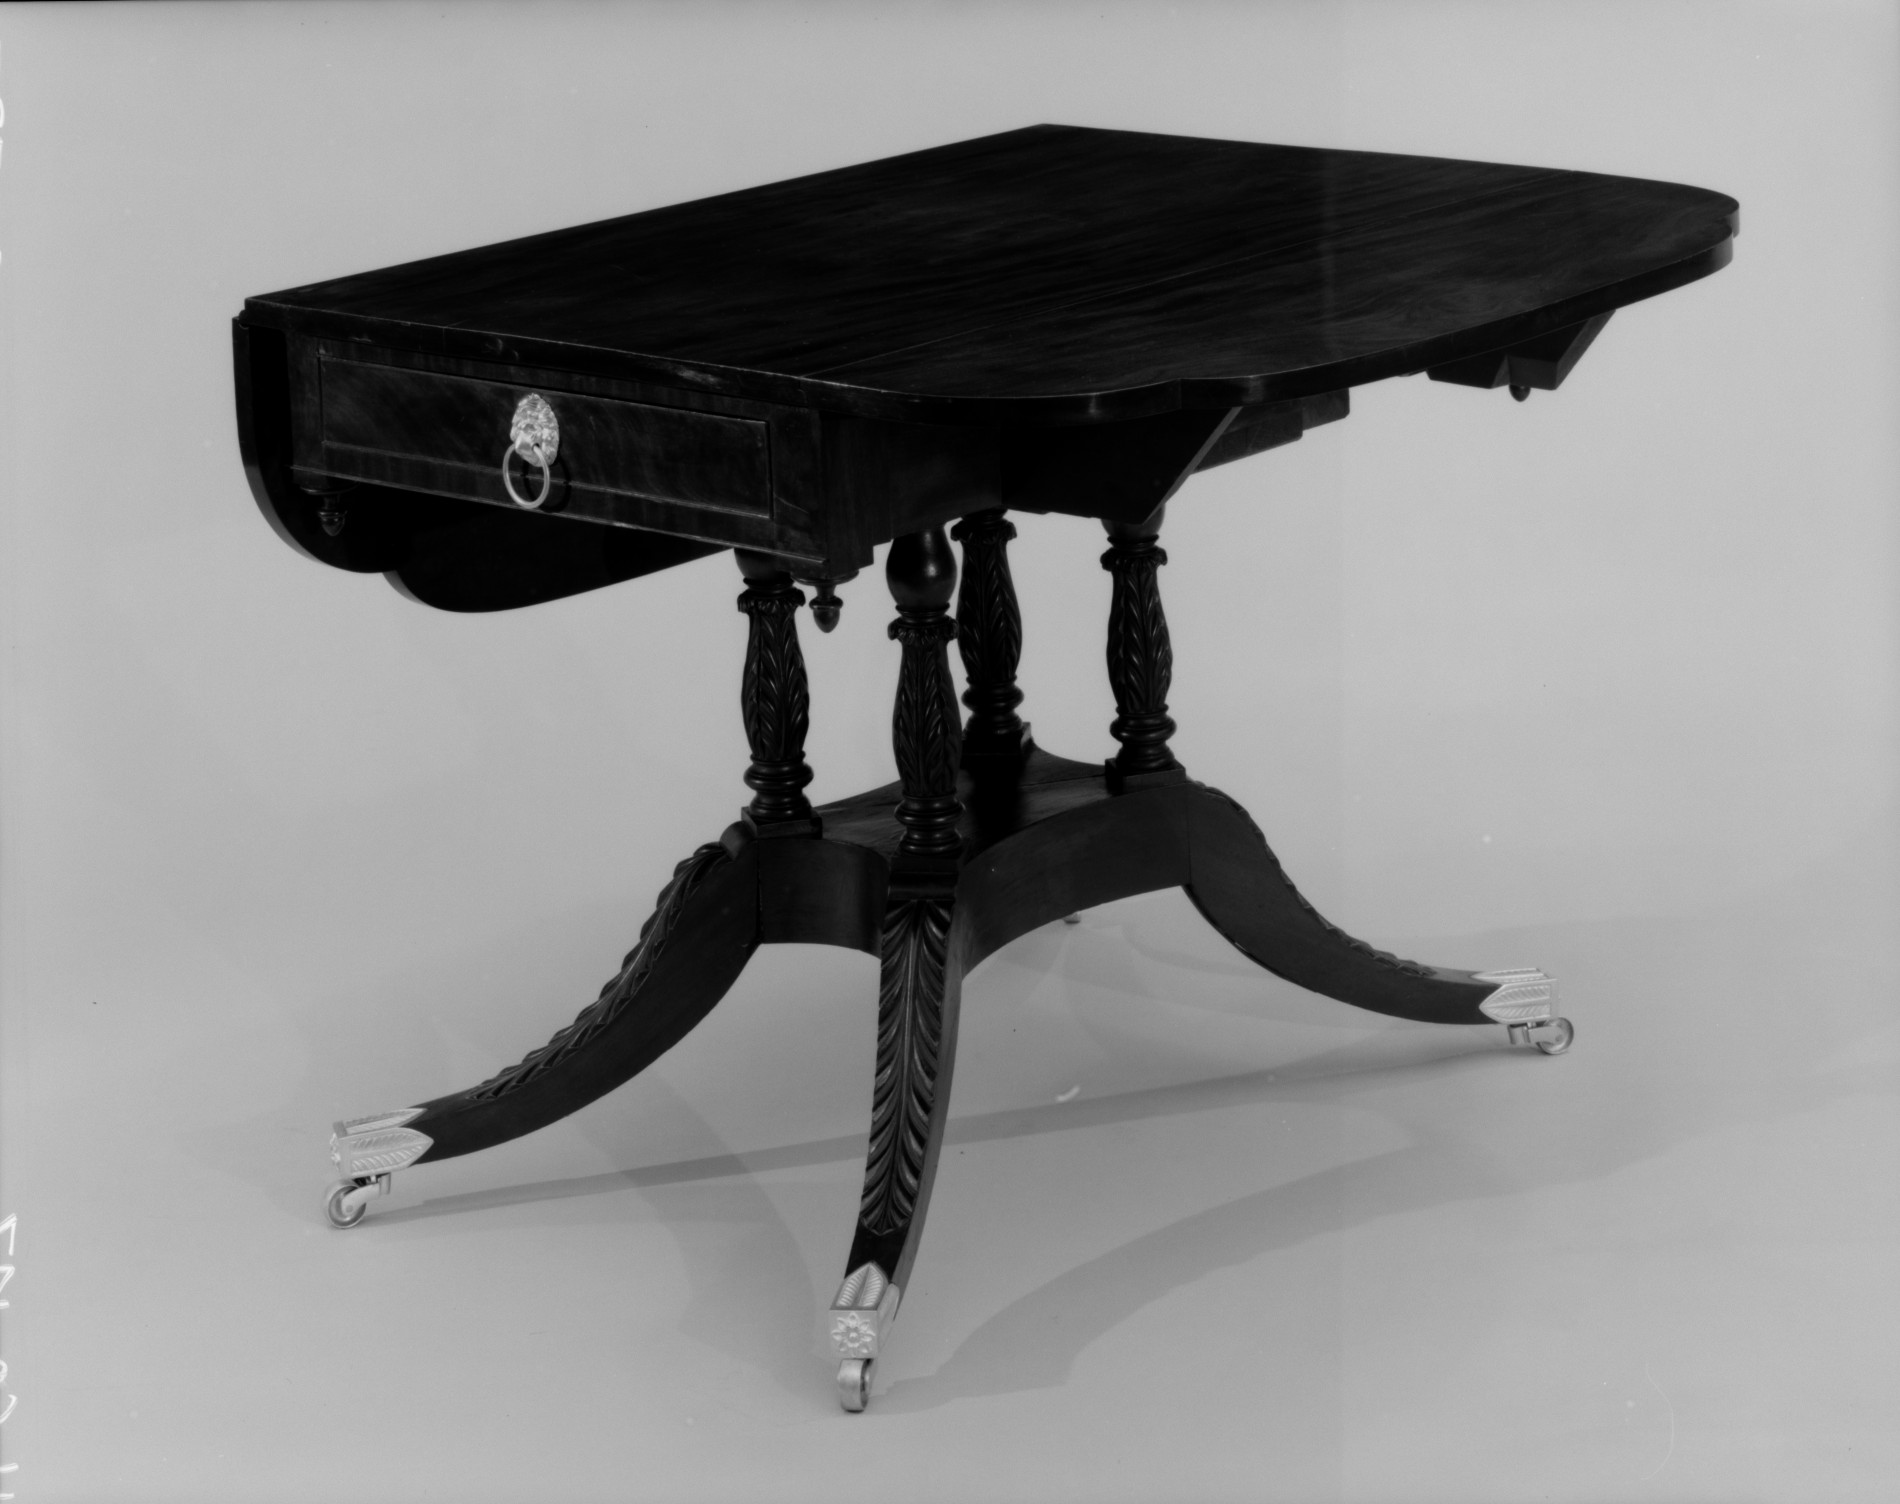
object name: drop leaf pembroke table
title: Drop-leaf Pembroke Table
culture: american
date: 1810-1820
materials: brass, gilt, wood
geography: united states